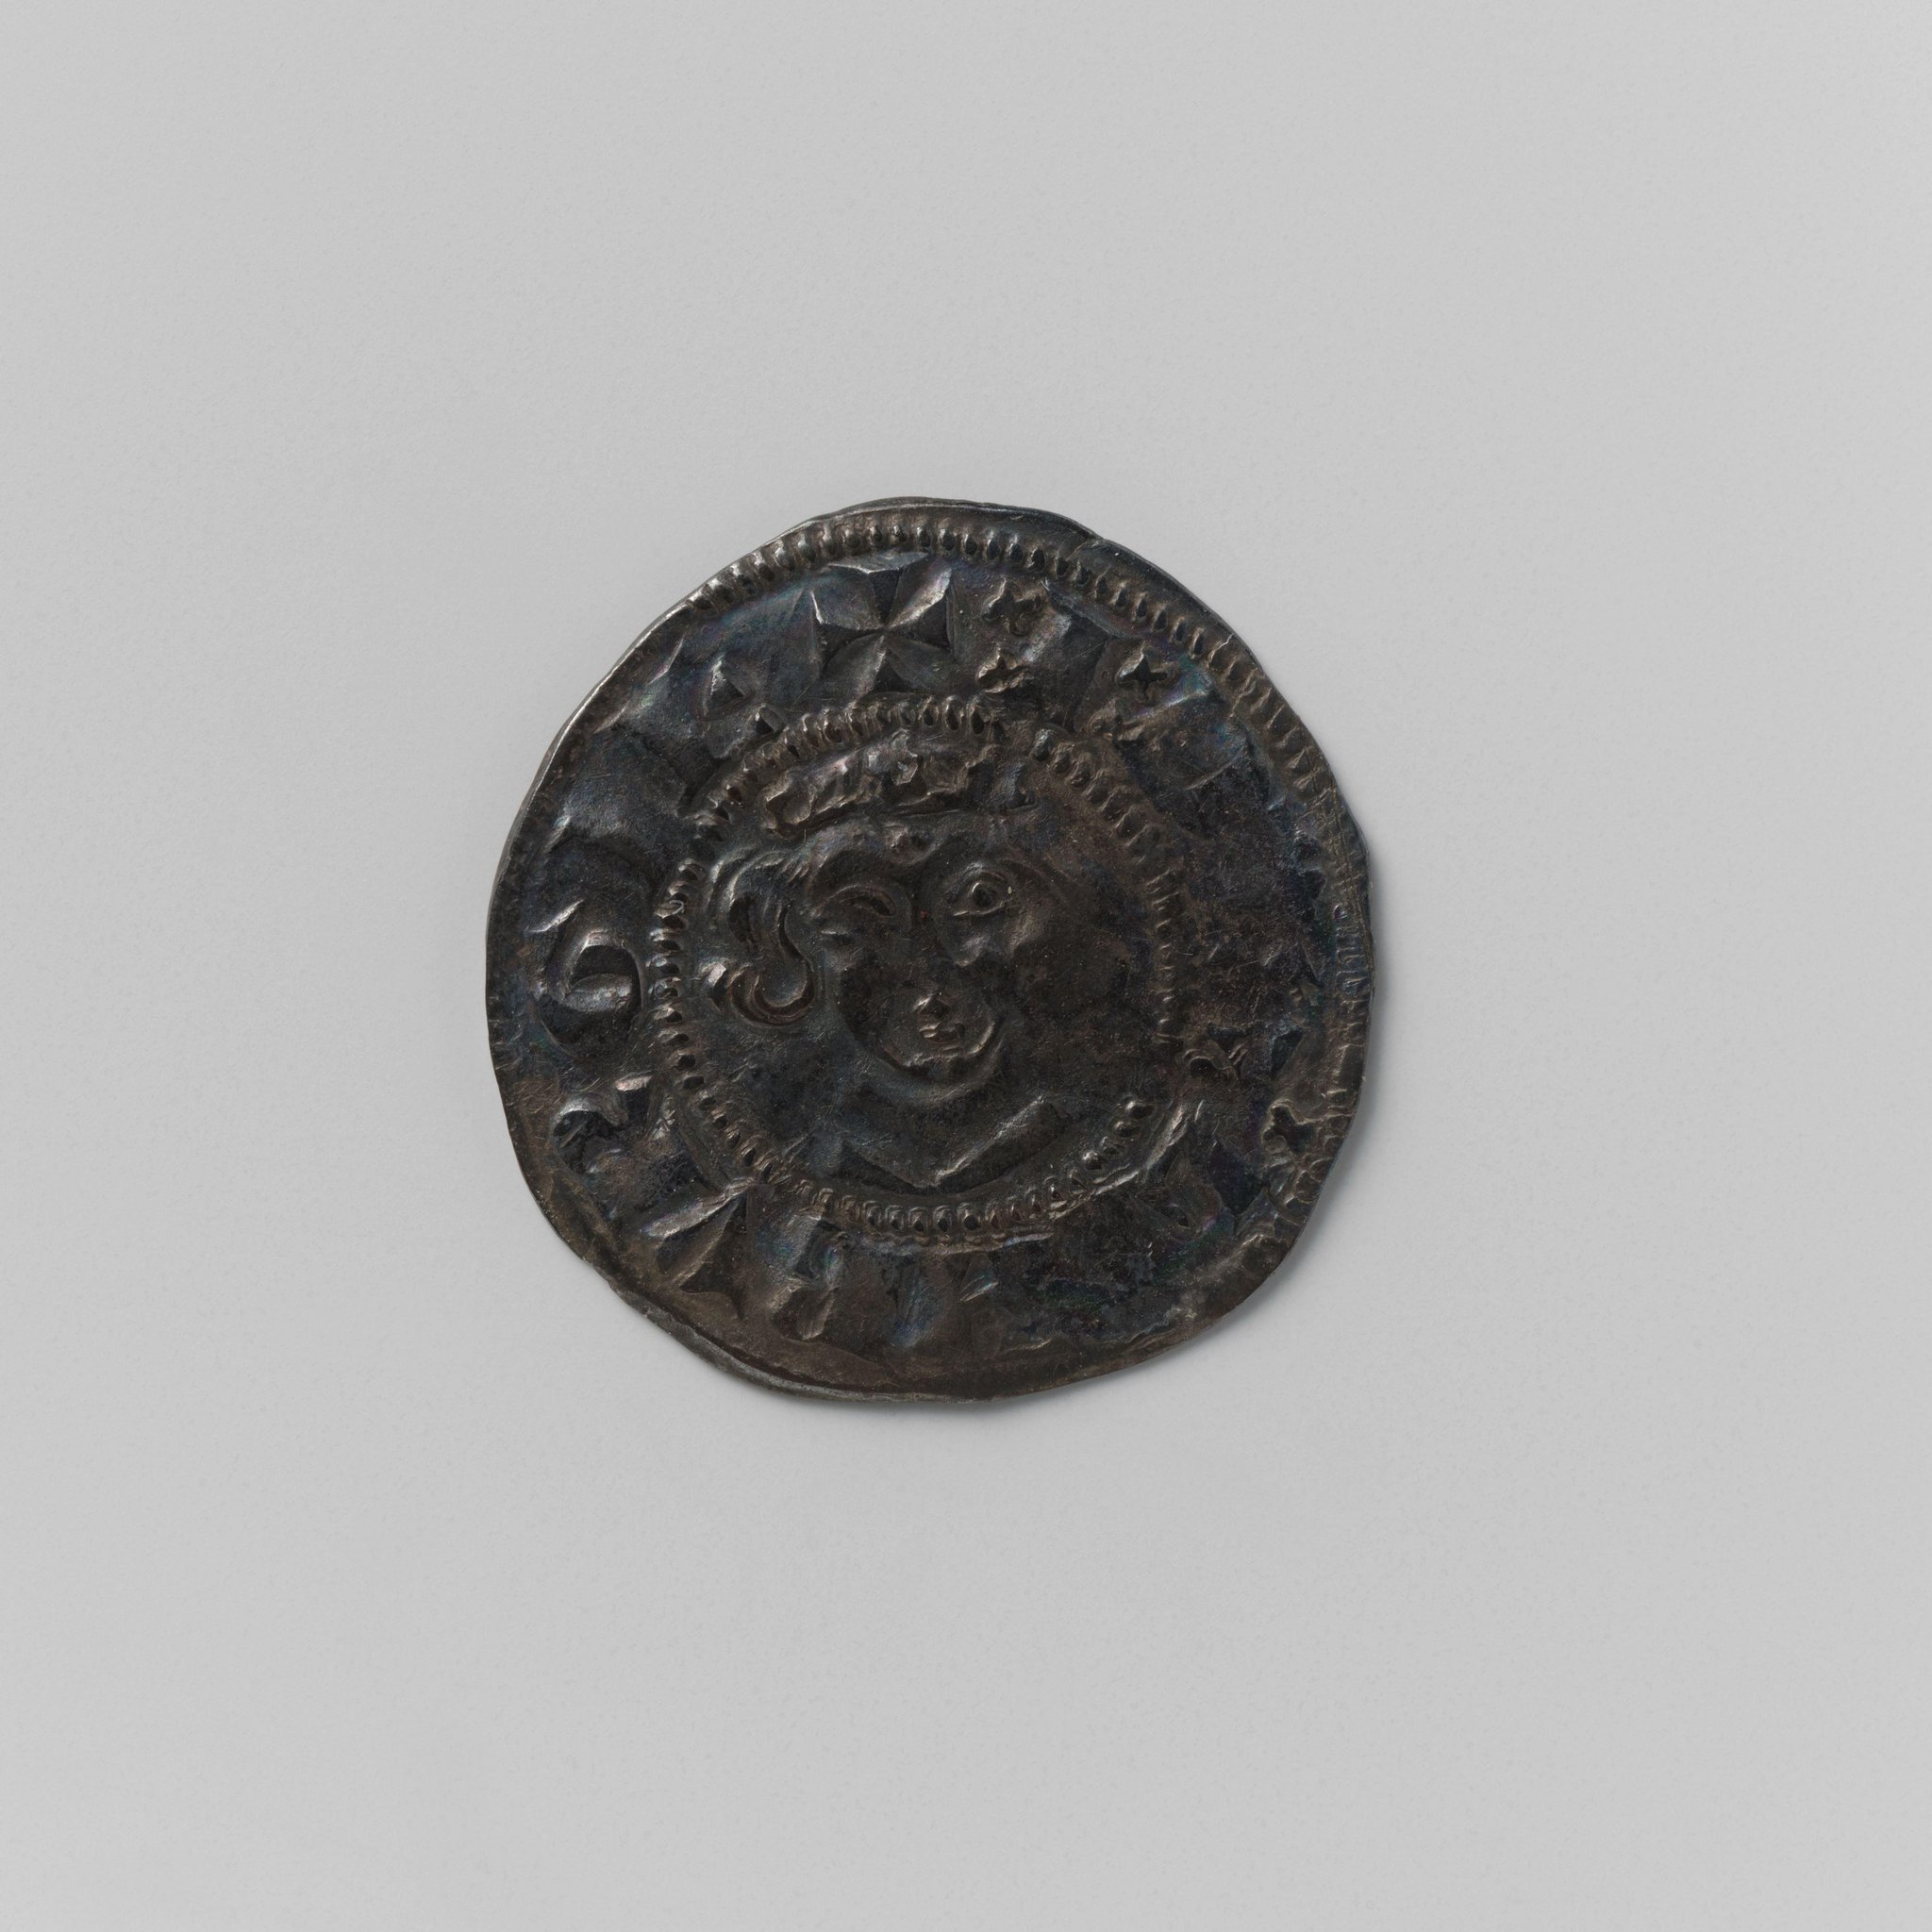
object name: coin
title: Brabant, Jan I, sterling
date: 1287-1294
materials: silver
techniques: striking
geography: maastricht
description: Voorzijde: aanziende persoon met rozenkrans. Keerzijde: lang kruis, in de hoeken roosjes.